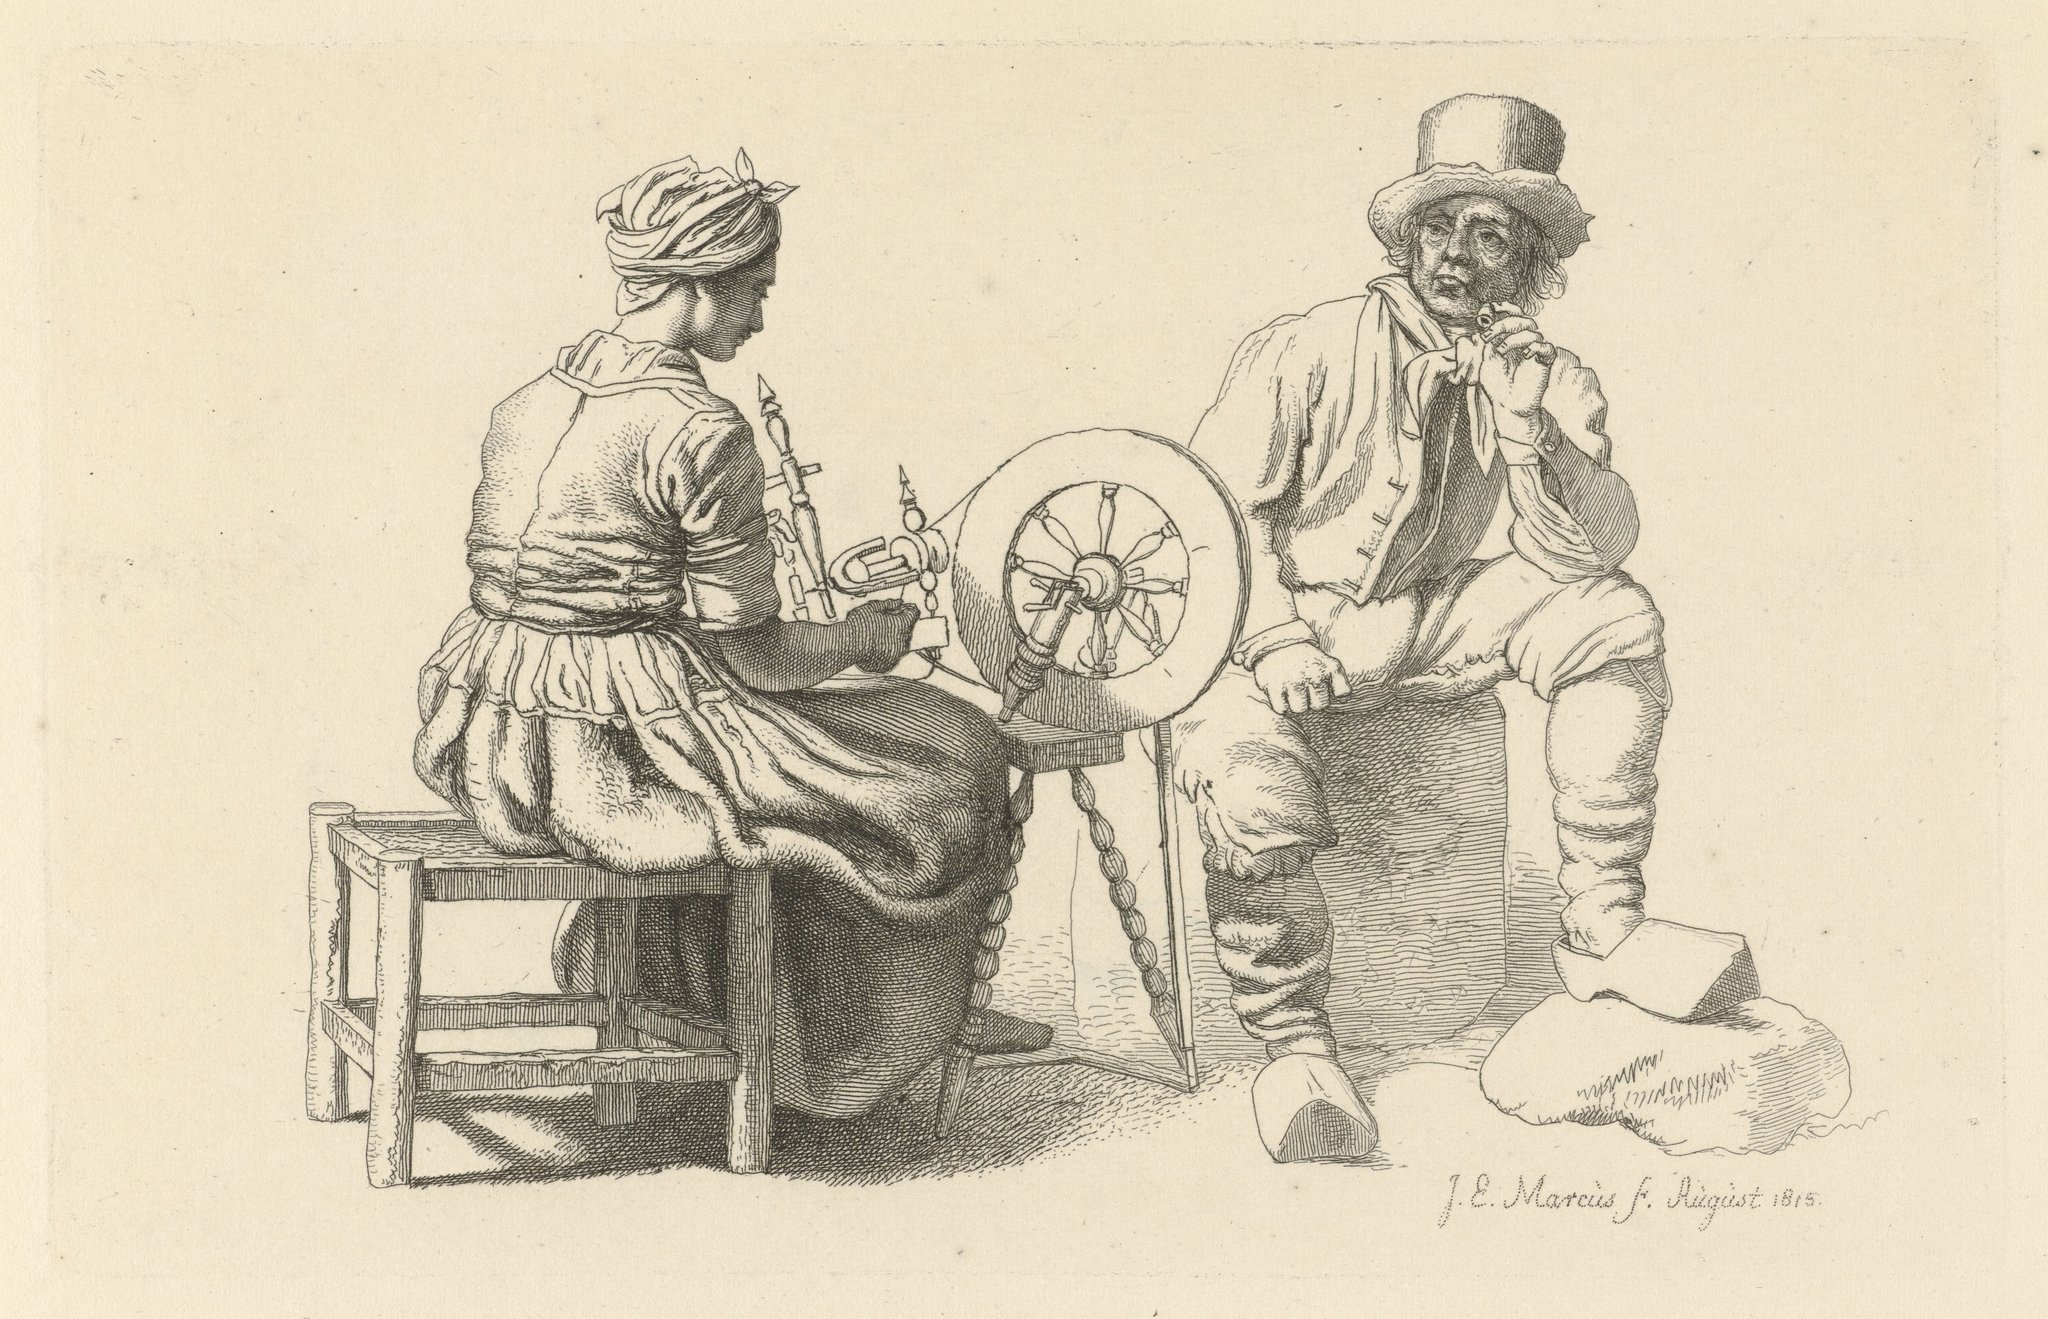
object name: print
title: Studieblad met een vrouw aan een spinnewiel en een zittende man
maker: jacob ernst marcus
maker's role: draughtsman, print maker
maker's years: 1774-1826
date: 1808-1815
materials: paper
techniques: etching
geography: amsterdam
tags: wooden shoes, clogs, pipe ~ tobacco, spinning-wheel, spinning (manufacture of yarn)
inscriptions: collector's mark: Lugt 2228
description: Serie voor het eerst uitgegeven door Jacob Ernst Marcus onder de titel Studiebeelden en Fragmenten. Amsterdam: ca.1816. Later heruitgegeven als: Studie-prentwerk/ Etudes gravées.